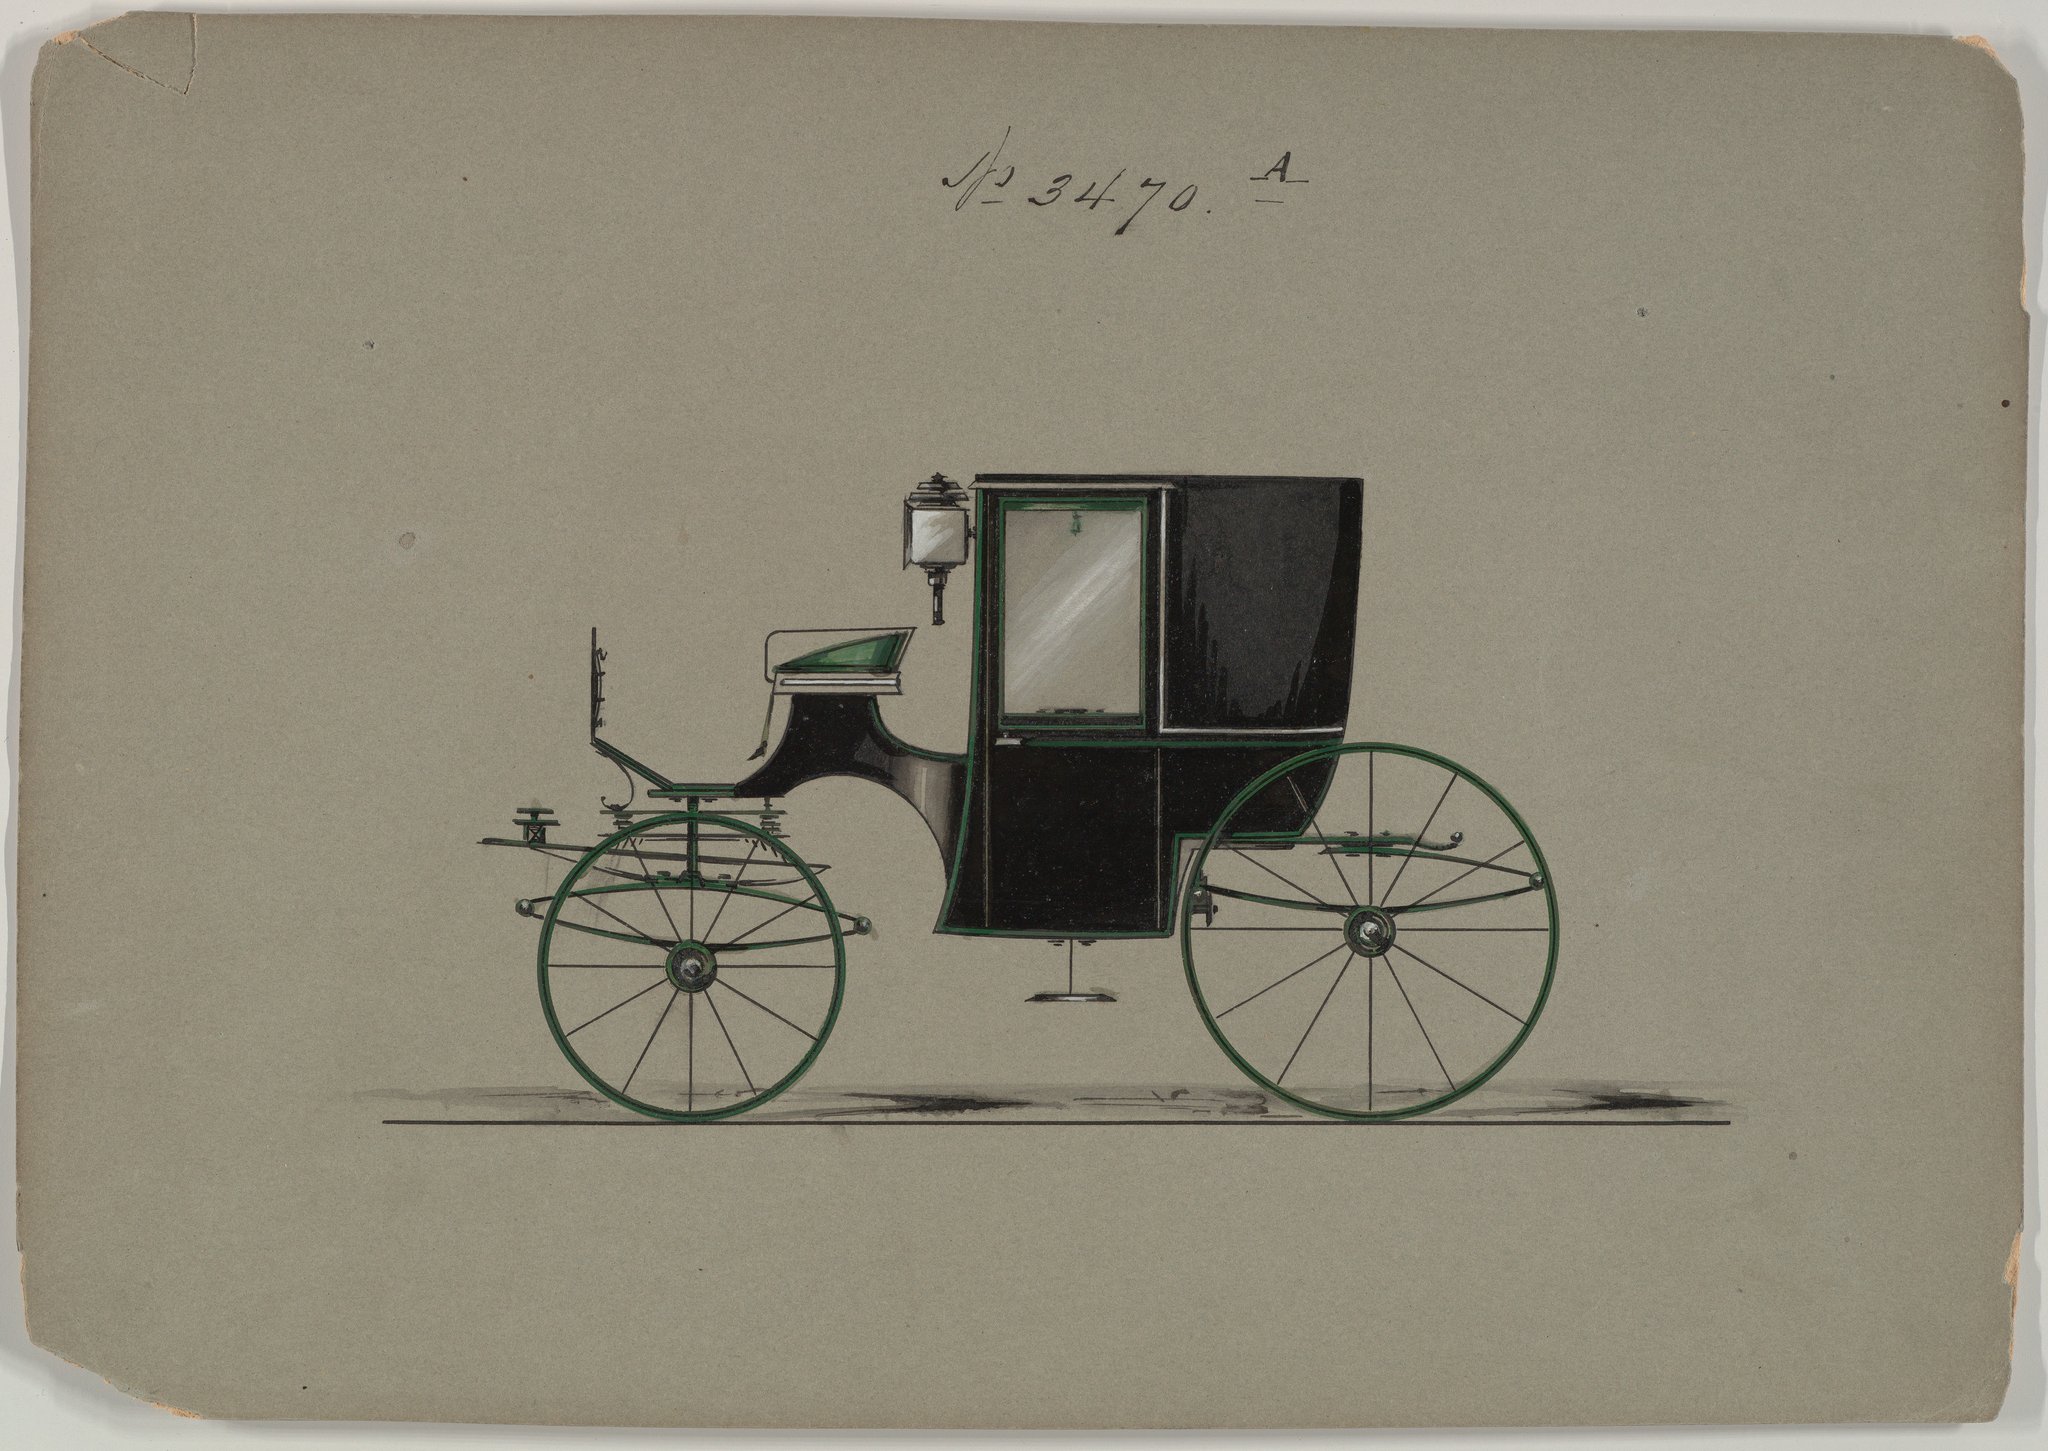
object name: drawing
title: Brougham, no. 3470A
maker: brewster & co.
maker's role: manufacturer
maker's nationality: american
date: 1878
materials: gouache, gum arabic, ink, watercolor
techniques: pen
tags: carriages